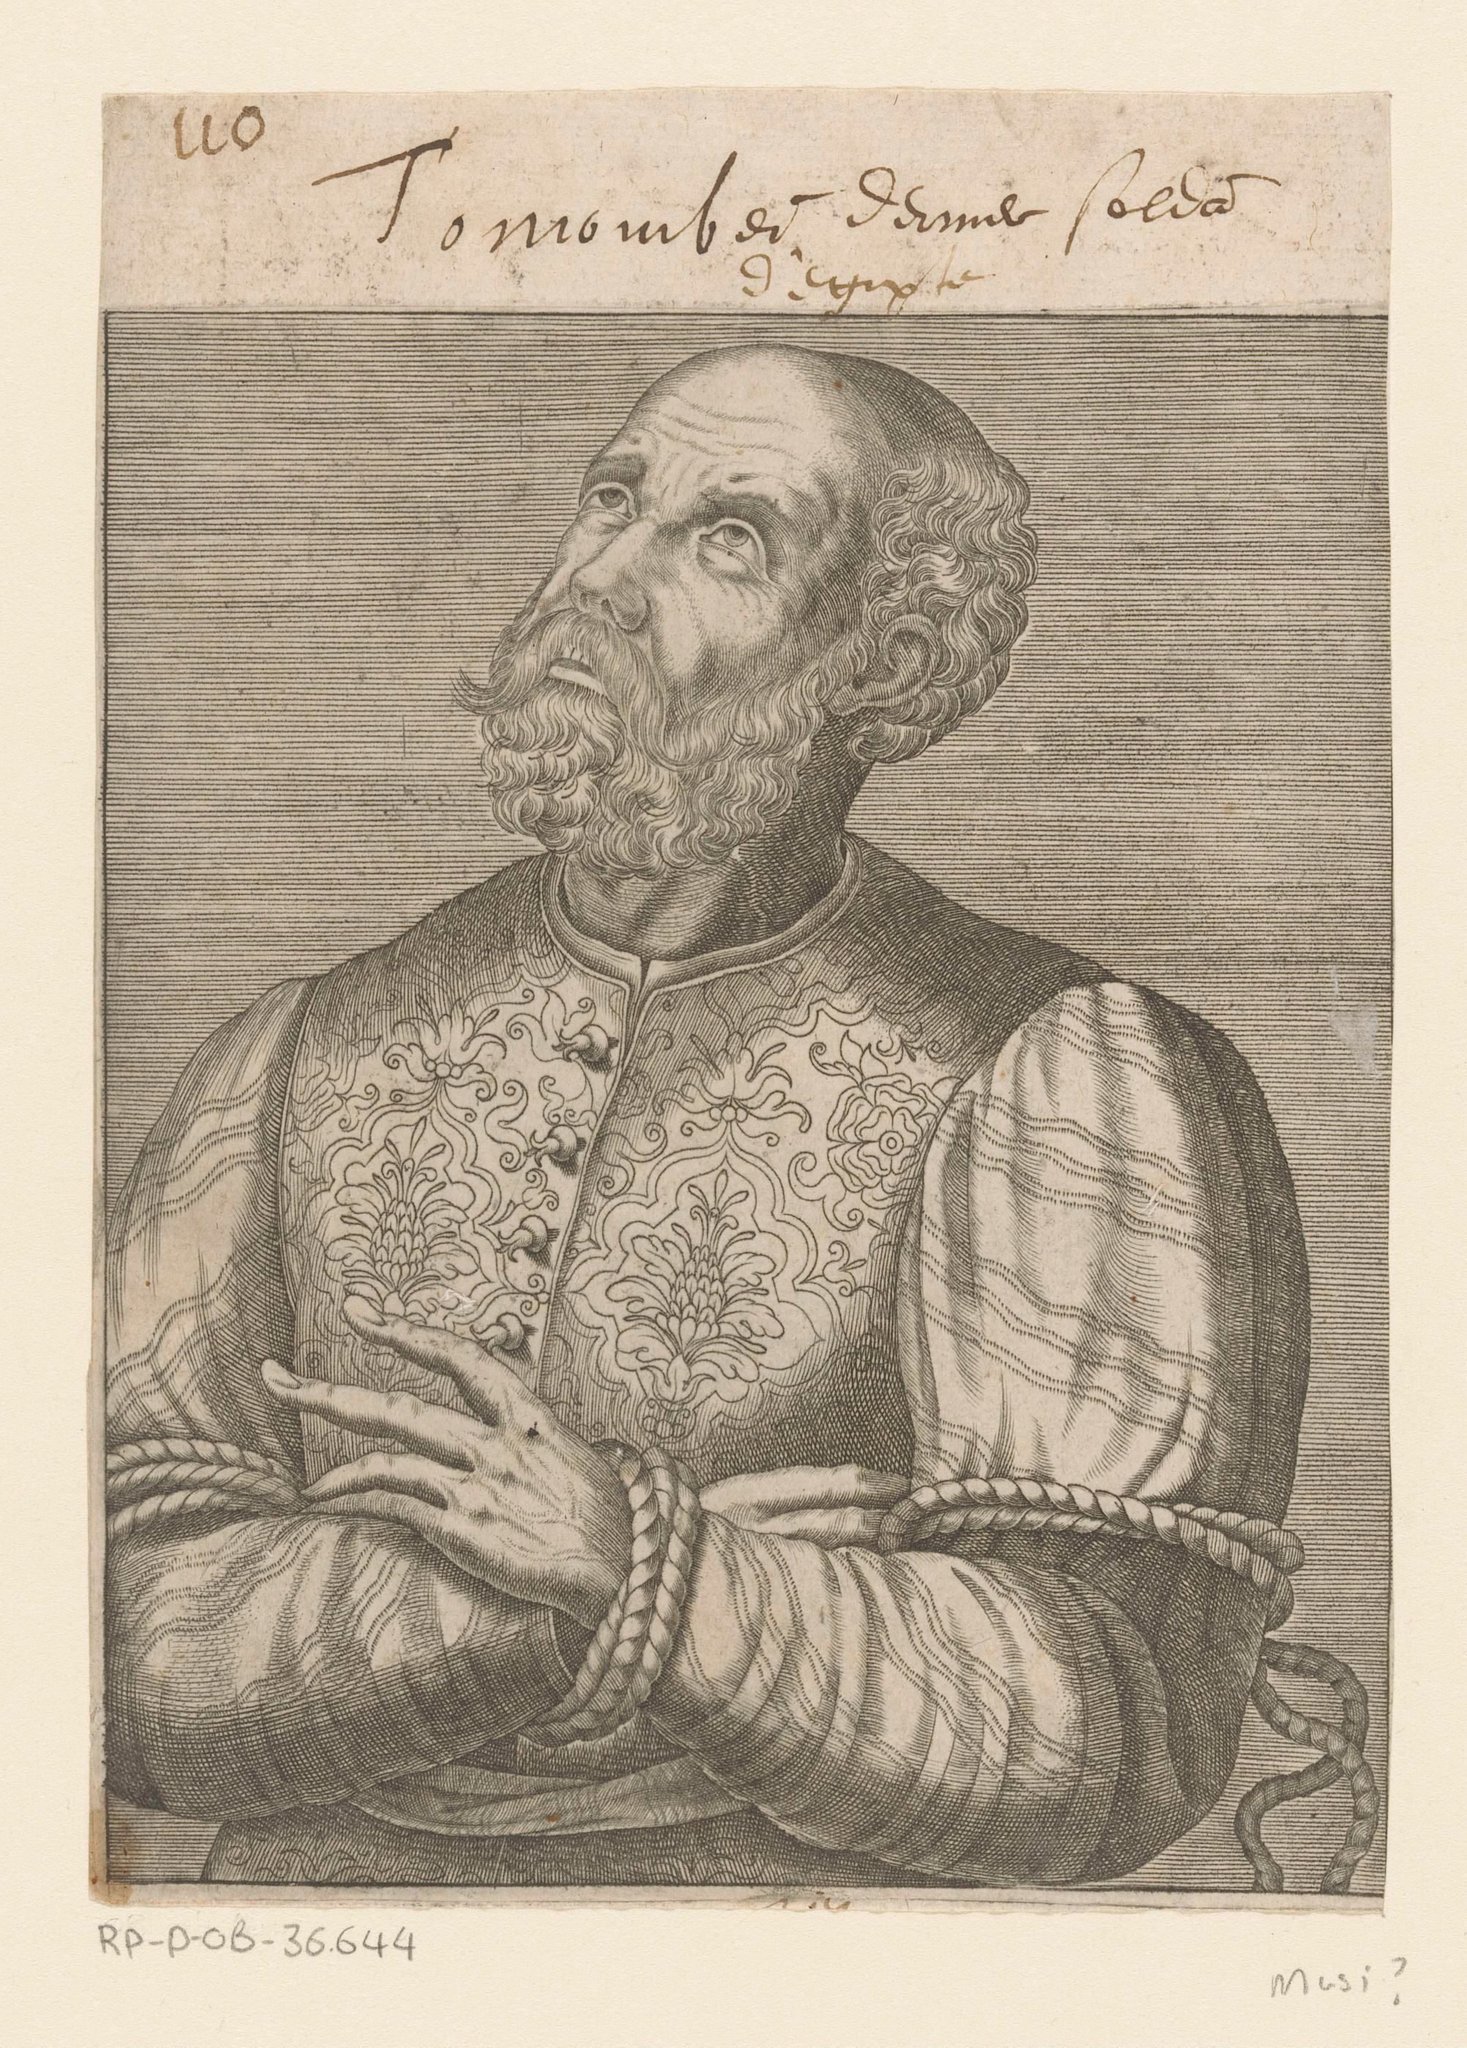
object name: print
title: Portret van Tuman Bay II, sultan van Egypte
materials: paper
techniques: engraving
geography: italy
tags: historical persons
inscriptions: inscription: ‘110 Tomombey [...] l'Egypte’, collector's mark: Lugt 2228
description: Deze prent werd gebruikt voor de publicatie 'Les vrais pourtraits et vies des hommes illustres grecz, latins et payens' van André Thevet, uitgegeven in 1584 te Parijs (dl. 3, p. 639 recto).